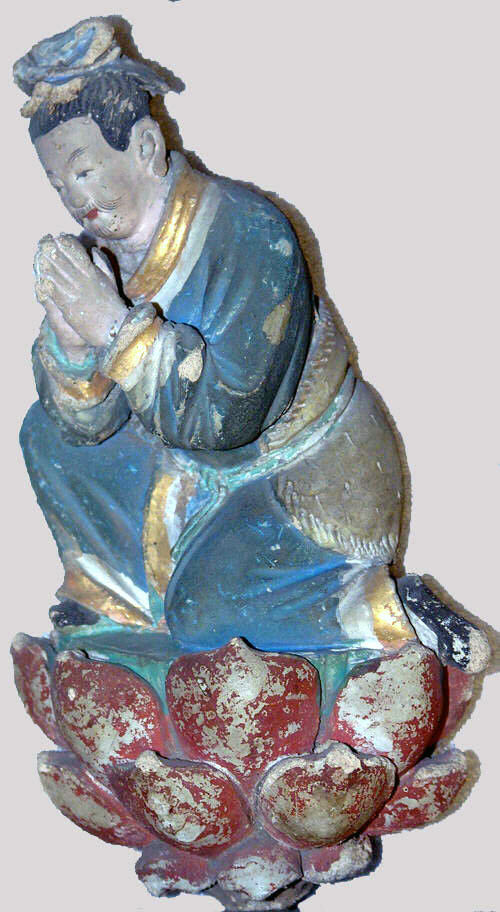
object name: statuette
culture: chinese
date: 1368-1644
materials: mud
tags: men